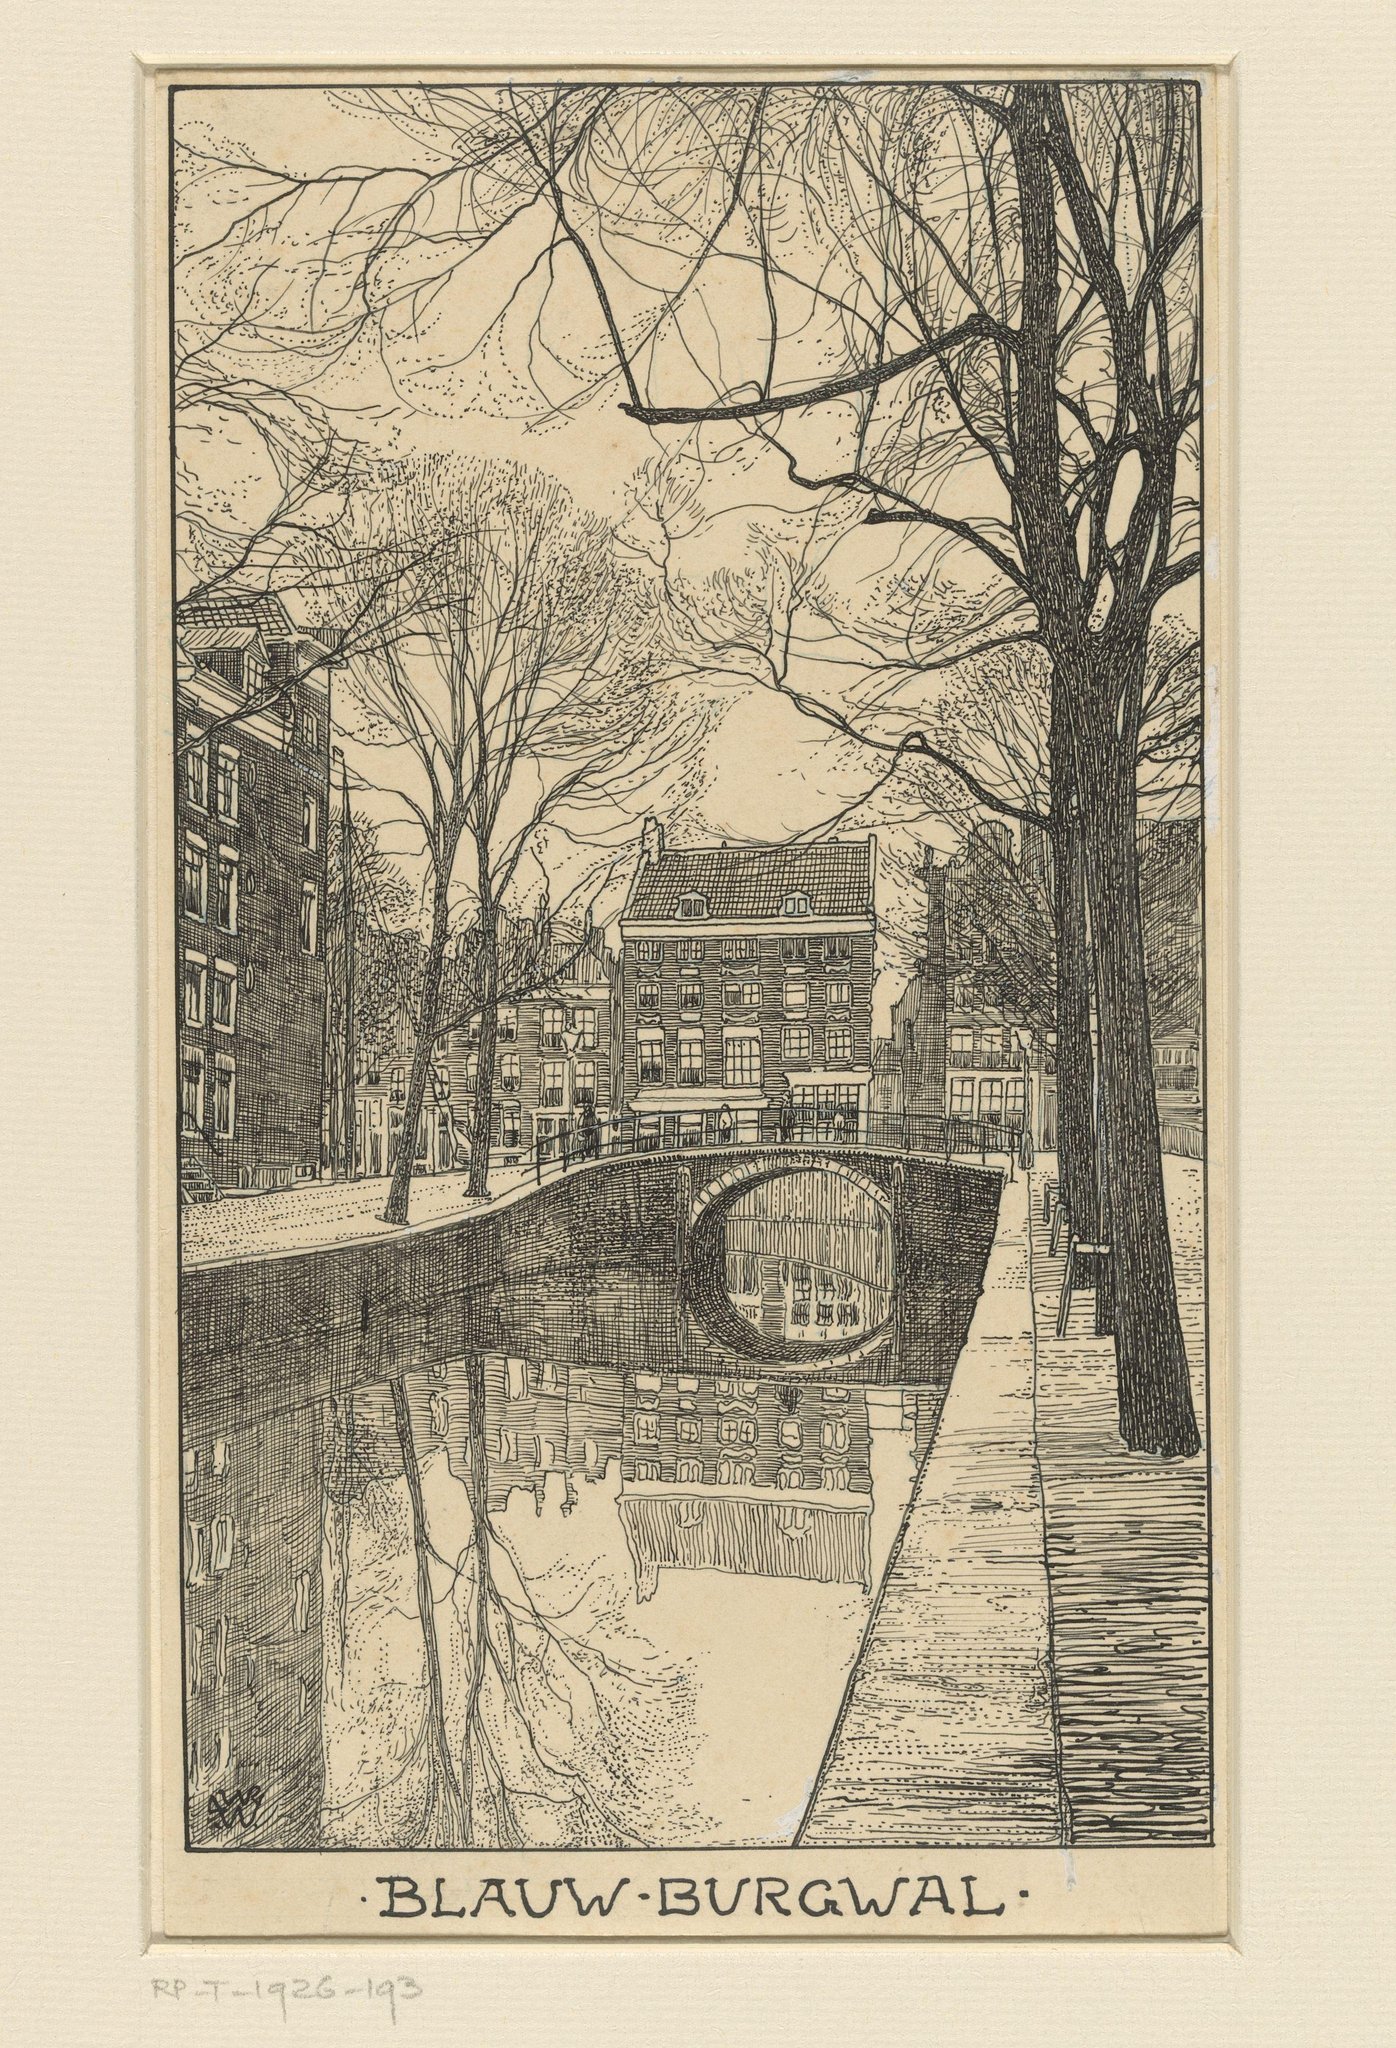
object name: drawing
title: Blauw Burgwal te Amsterdam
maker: willem wenckebach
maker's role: designer, draughtsman, painter, print maker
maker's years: 1860-1937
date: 1870-1926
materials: paint, ink, paper, pencil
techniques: pen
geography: amsterdam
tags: canals, waters (in city), street, amsterdam